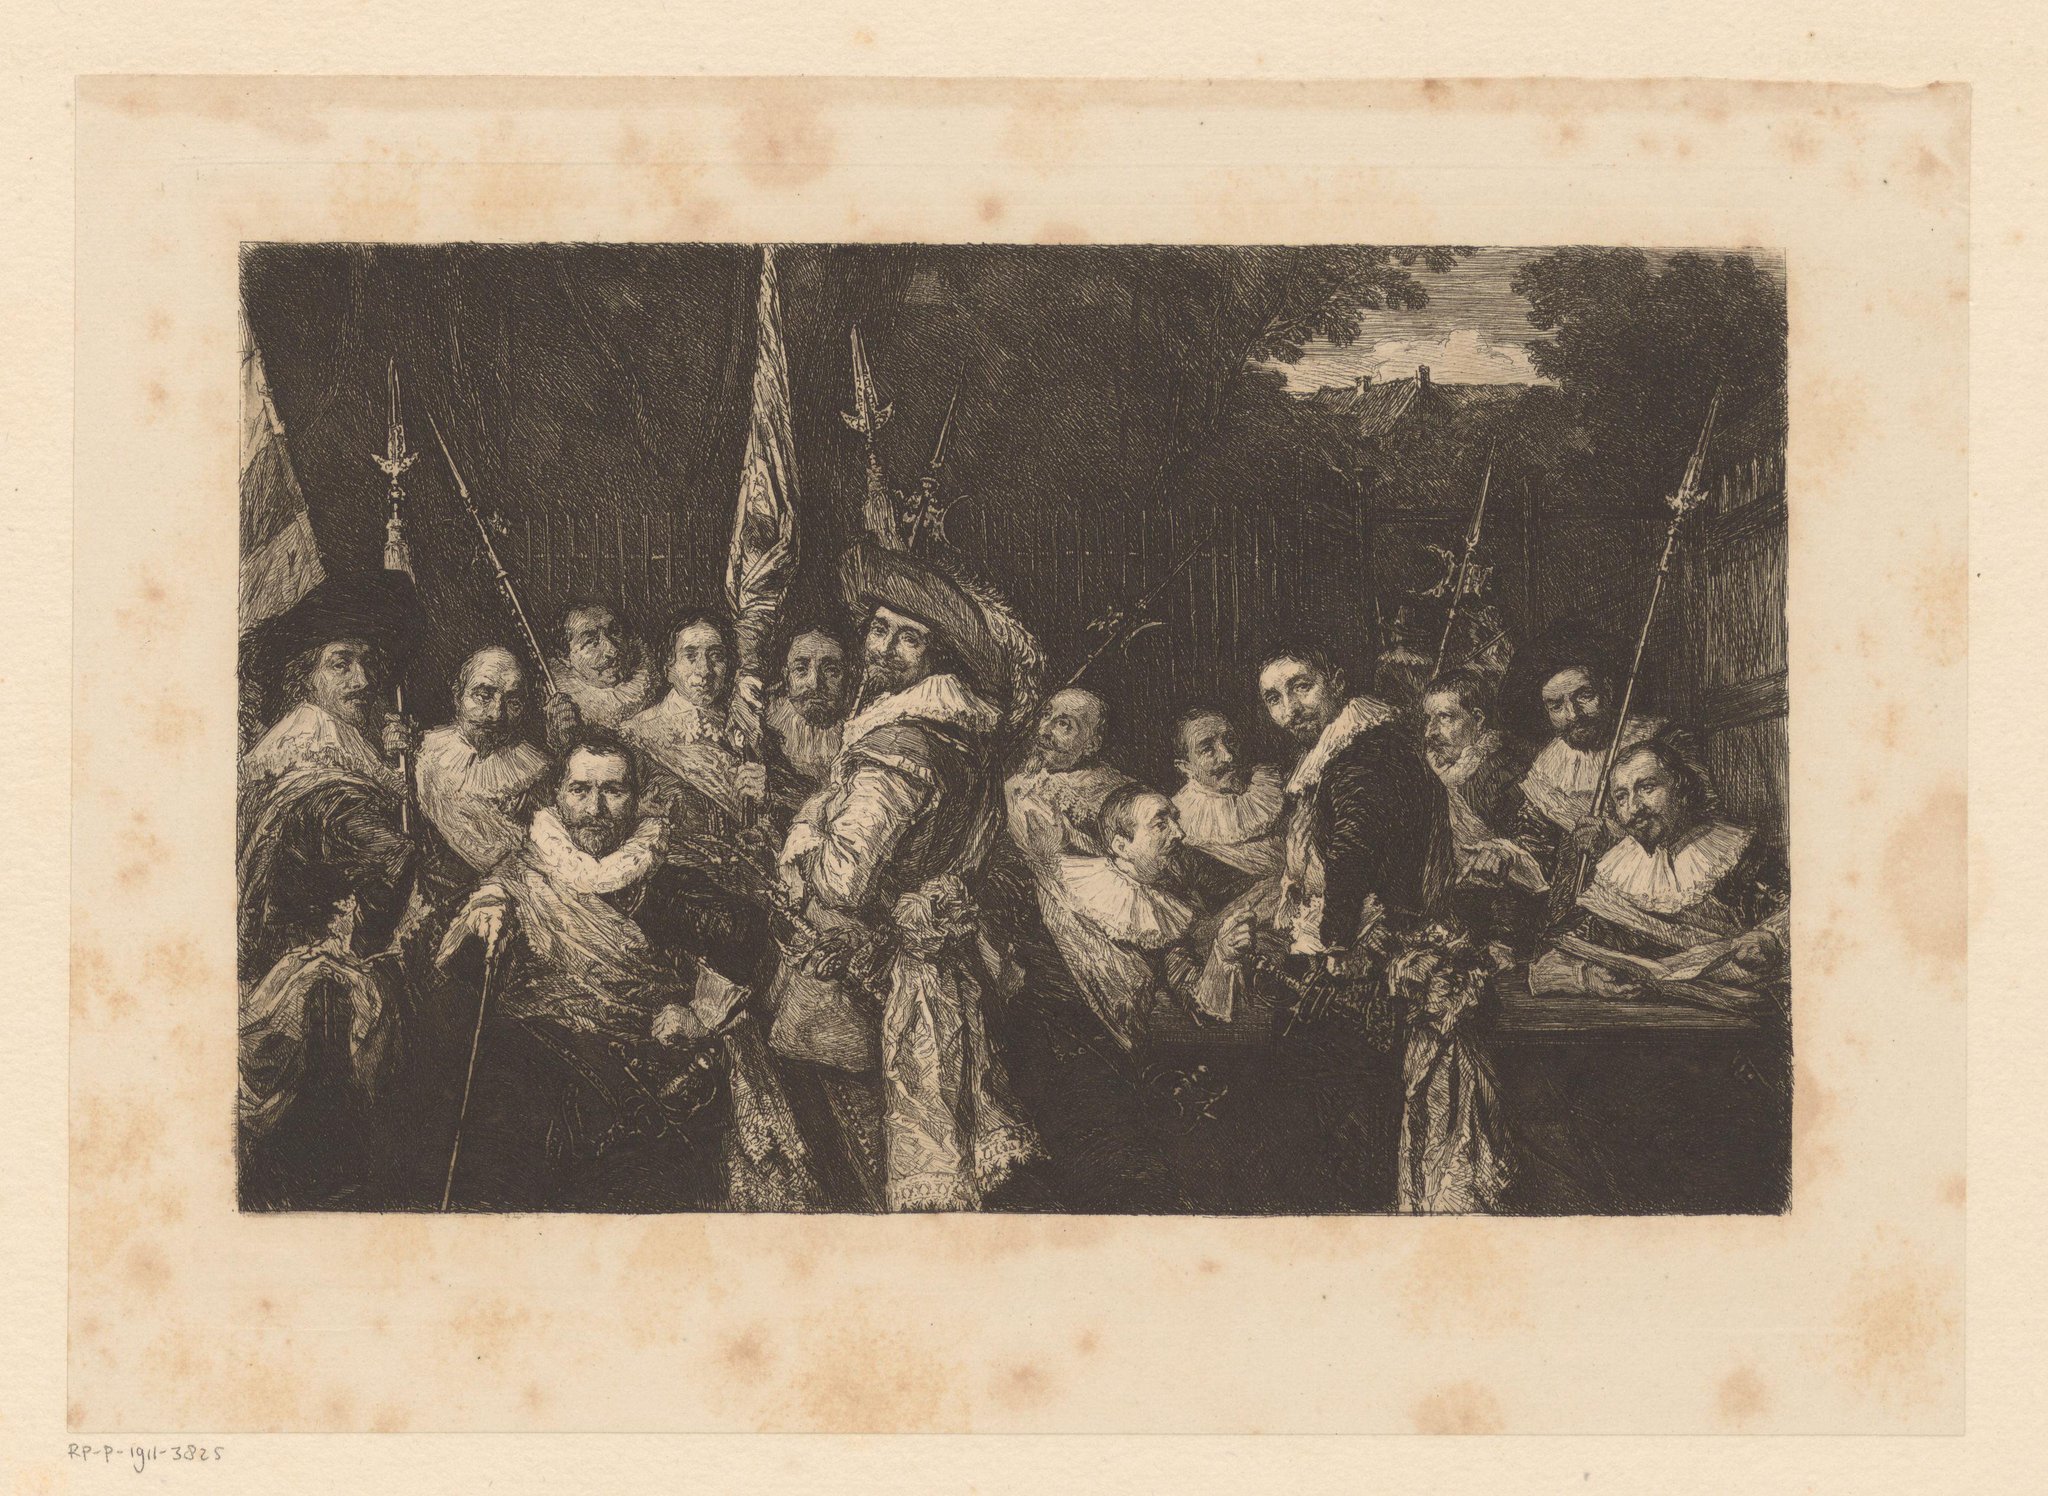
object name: print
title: Vergadering van officieren en onderofficieren van de Haarlemse Cluveniersschutterij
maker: william unger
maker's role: draughtsman, painter, print maker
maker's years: 1837-1932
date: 1847-1889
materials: paper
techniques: etching, intaglio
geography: germany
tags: haarlem, mayor, amsterdam, painter, draughtsman, hendrik gerritsz pot, pieter jacobsz. olycan, (military) standard-bearer, warfare; military affairs (+ citizen soldiery, civil guard, citizen militia), historical persons (portraits and scenes from the life)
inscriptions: collector's mark: Lugt 2228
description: Prent naar het schilderij door Frans Hals in het Frans Halsmuseum te Haarlem (inv.nr. os I-112).